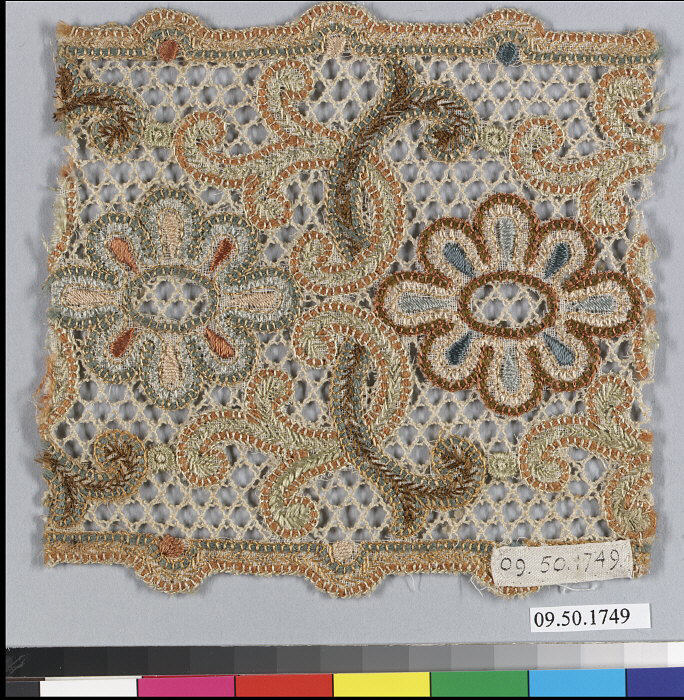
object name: fragment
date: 1801-1900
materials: lace